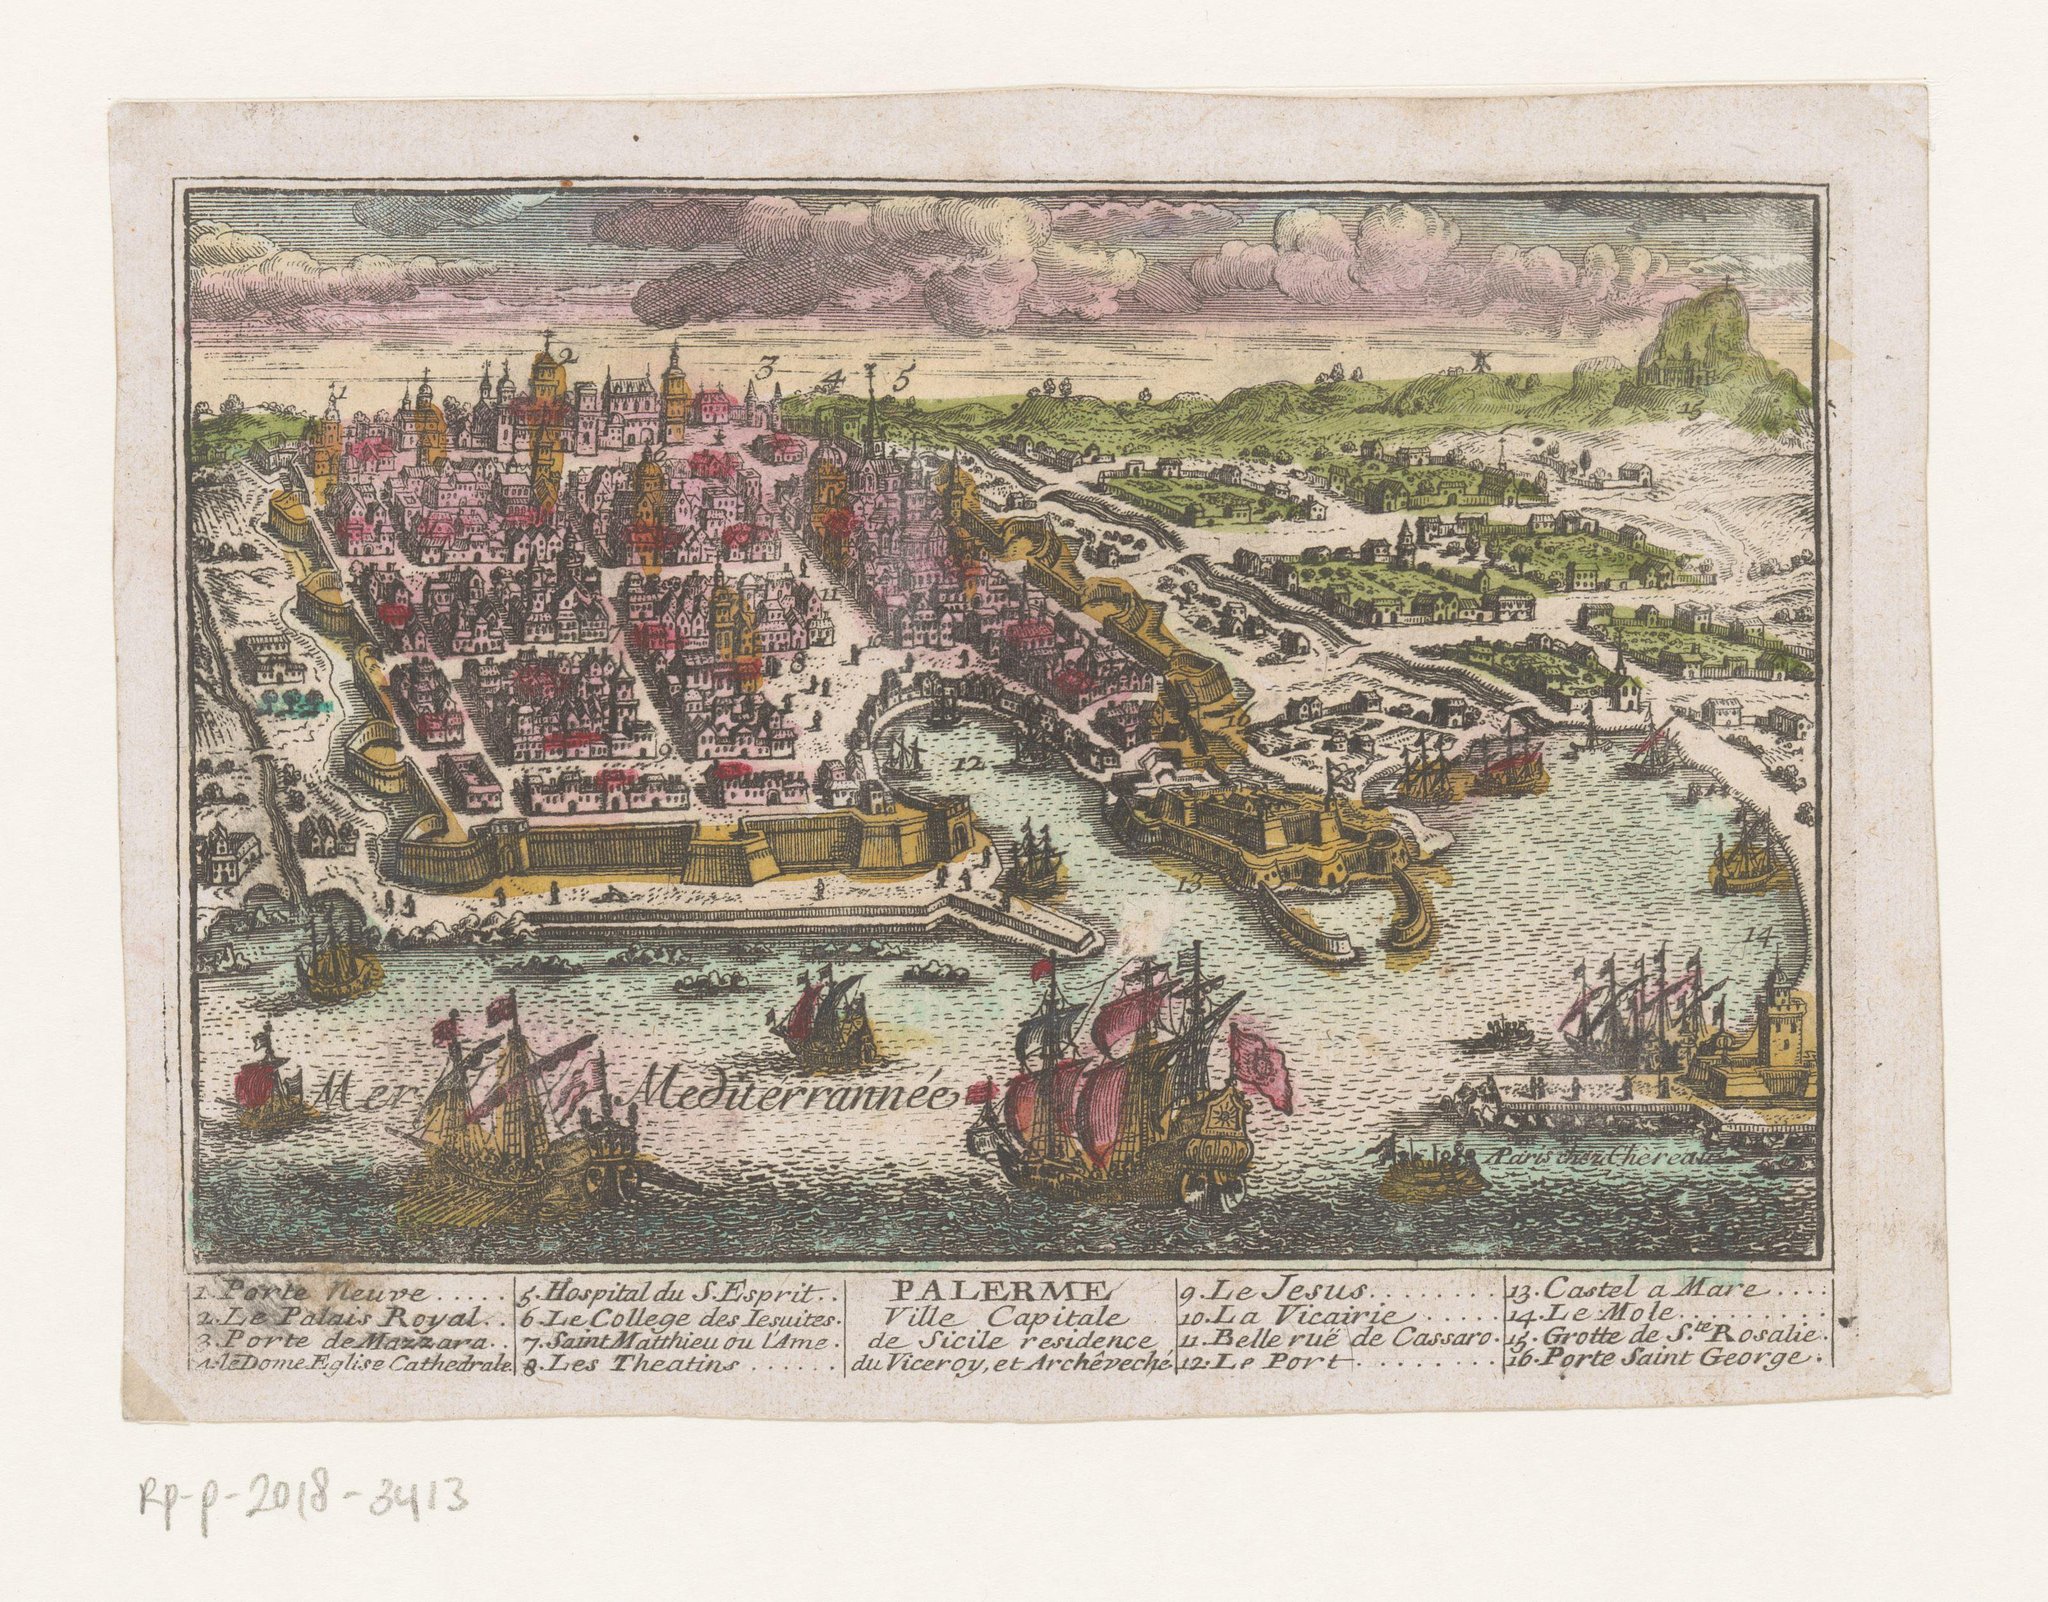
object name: print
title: Gezicht op Palermo te Sicilië in vogelvlucht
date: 1690-1729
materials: paper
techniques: etching, hand coloring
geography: paris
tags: city-view, and landscape with man-made constructions, maps, atlases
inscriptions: collector's mark: Lugt 2228